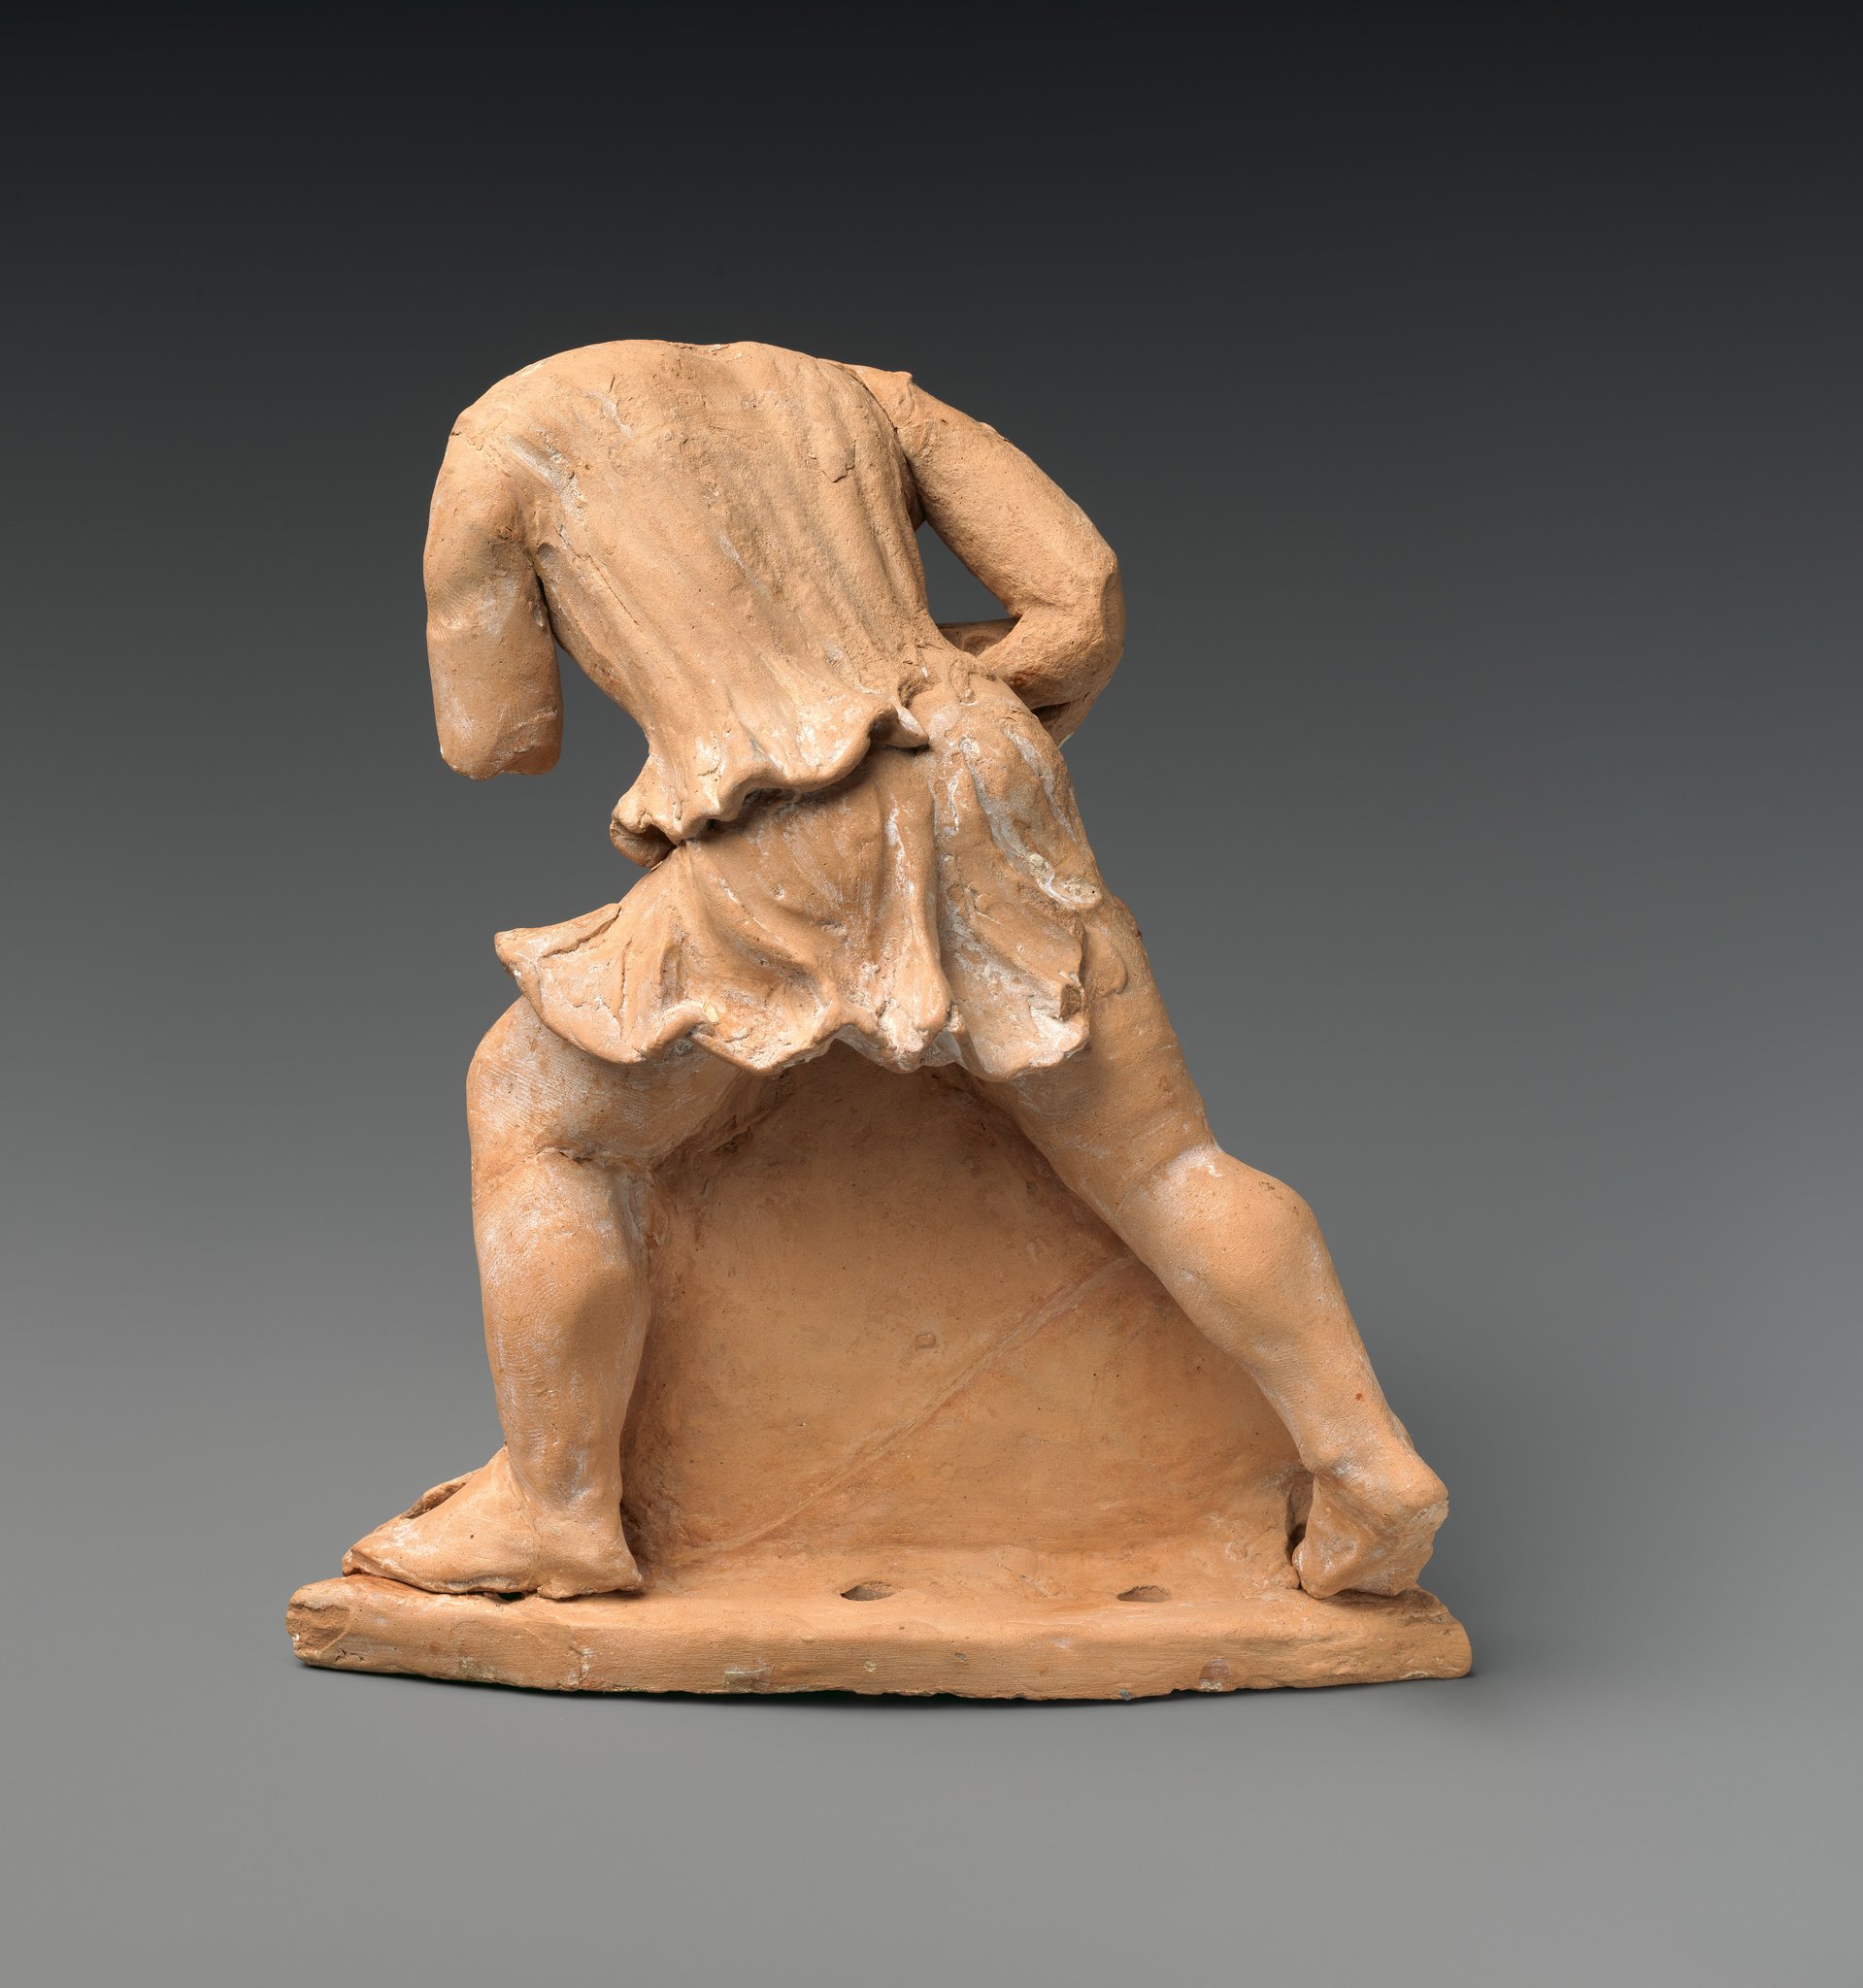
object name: relief from funnel jar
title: Terracotta relief detached from a funnel-jar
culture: canosan or south italian or italic-native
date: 334-268 BCE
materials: terracotta